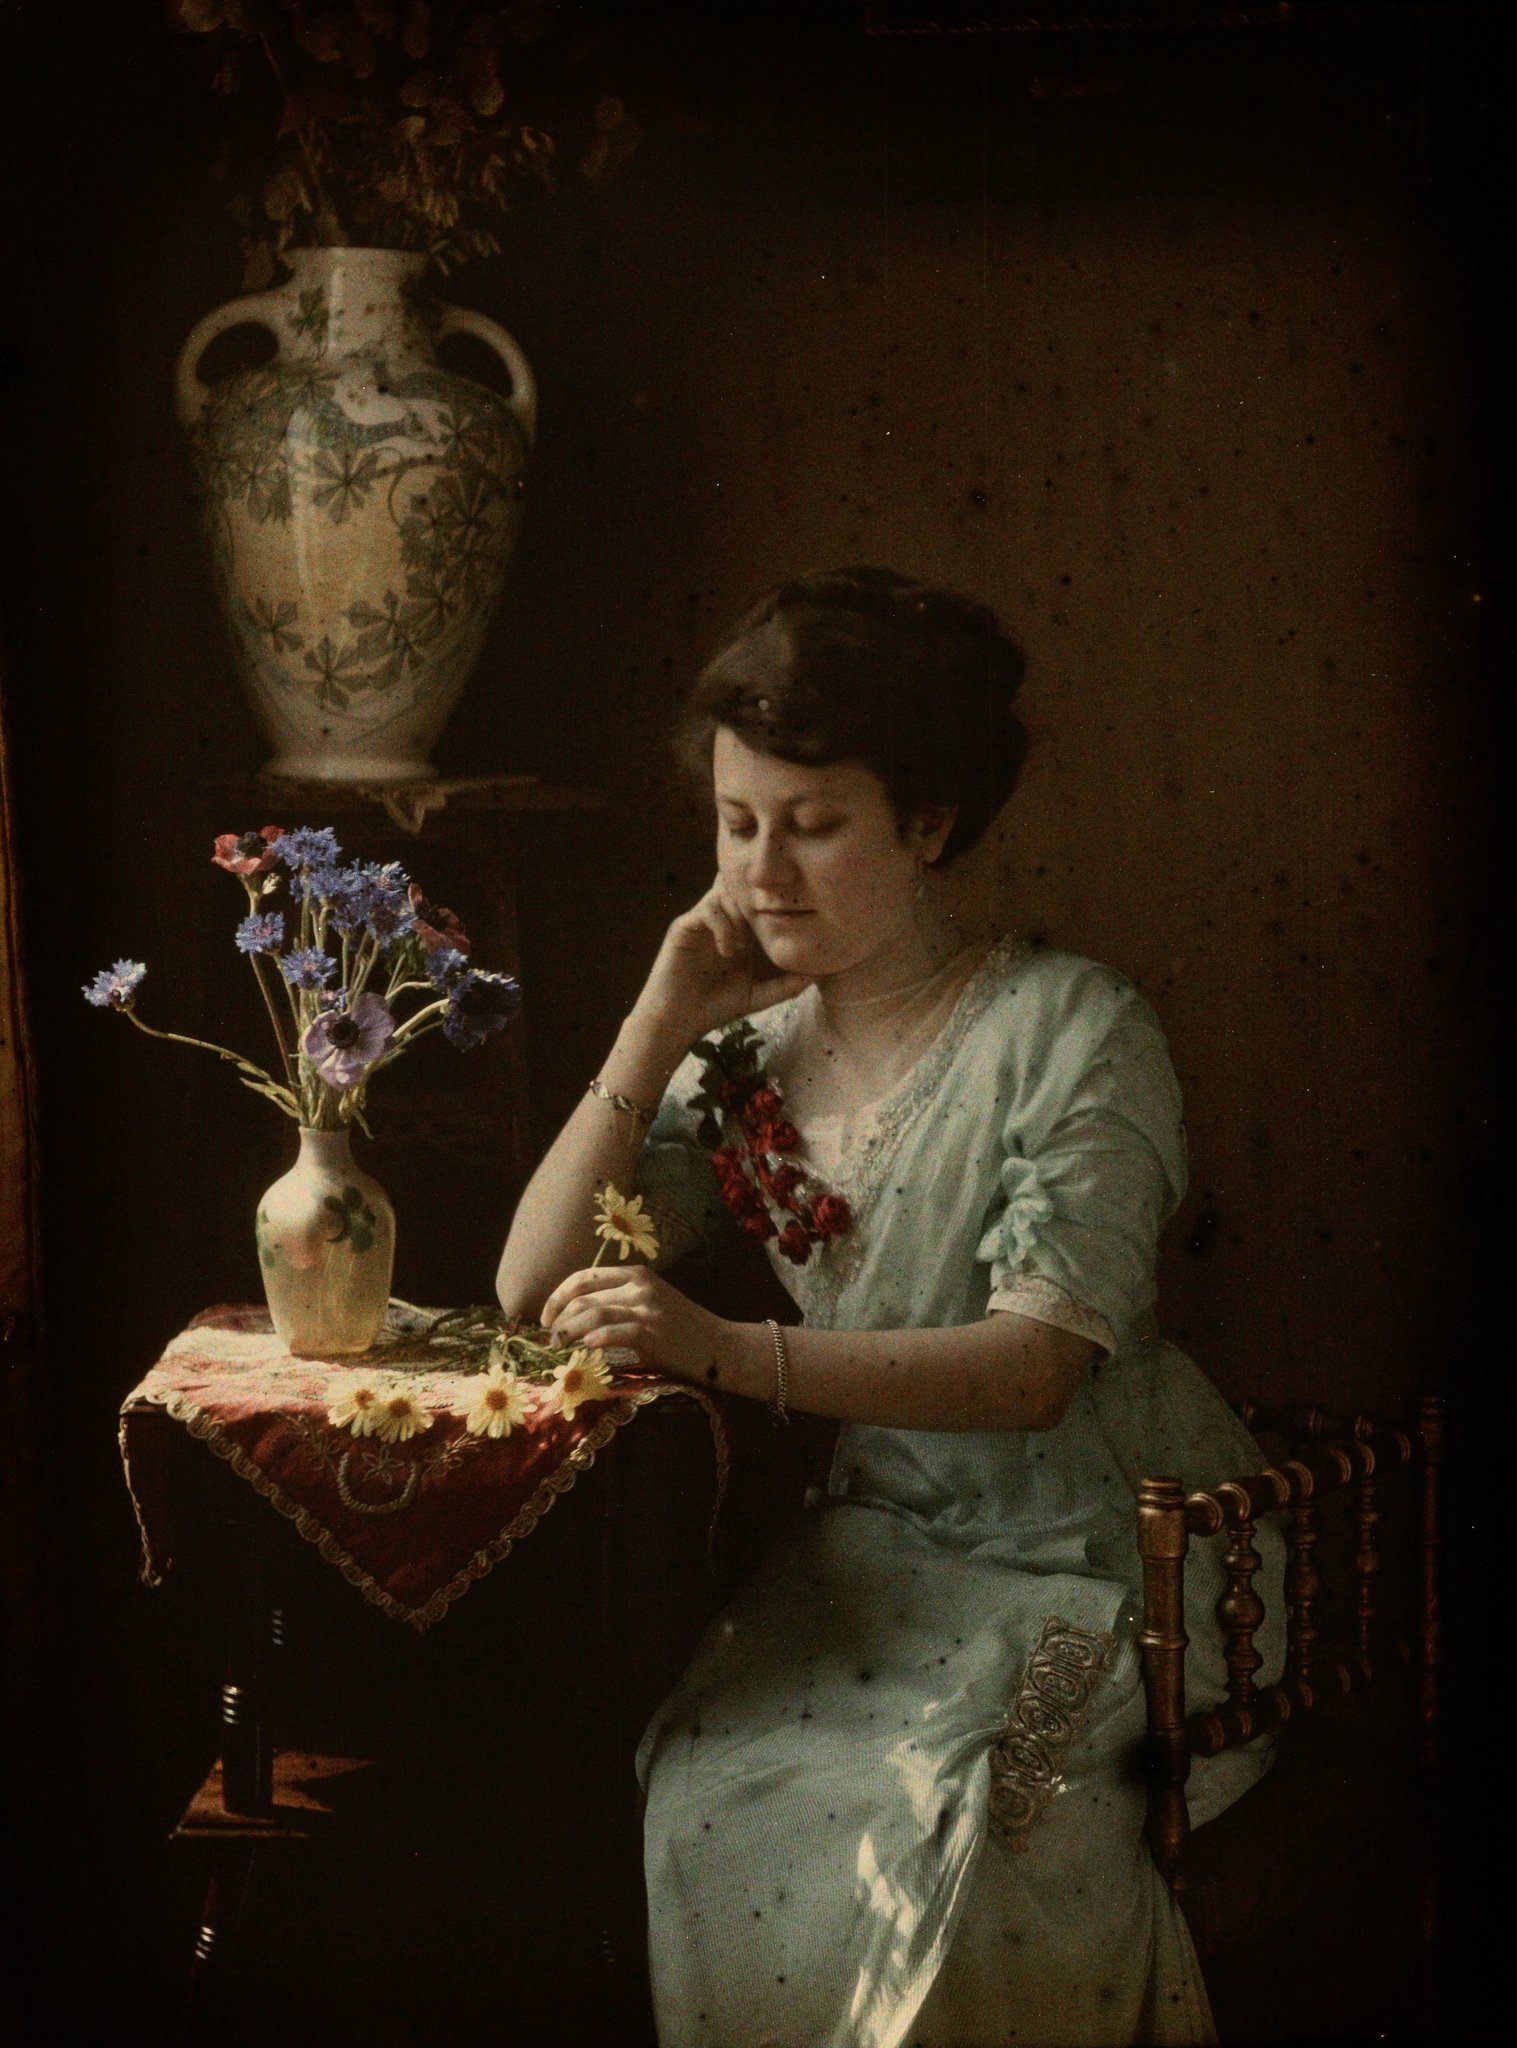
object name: photograph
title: Vrouw met bloemen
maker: johannes hendrikus antonius maria lutz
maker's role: fotograaf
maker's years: -1916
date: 1907-1916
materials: glass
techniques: autochrome process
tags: sitting figure - aa - female human figure, interior of the house, flowers in a vase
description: Vrouw zittend bij een kleine tafel waarop een vaas met bloemen.